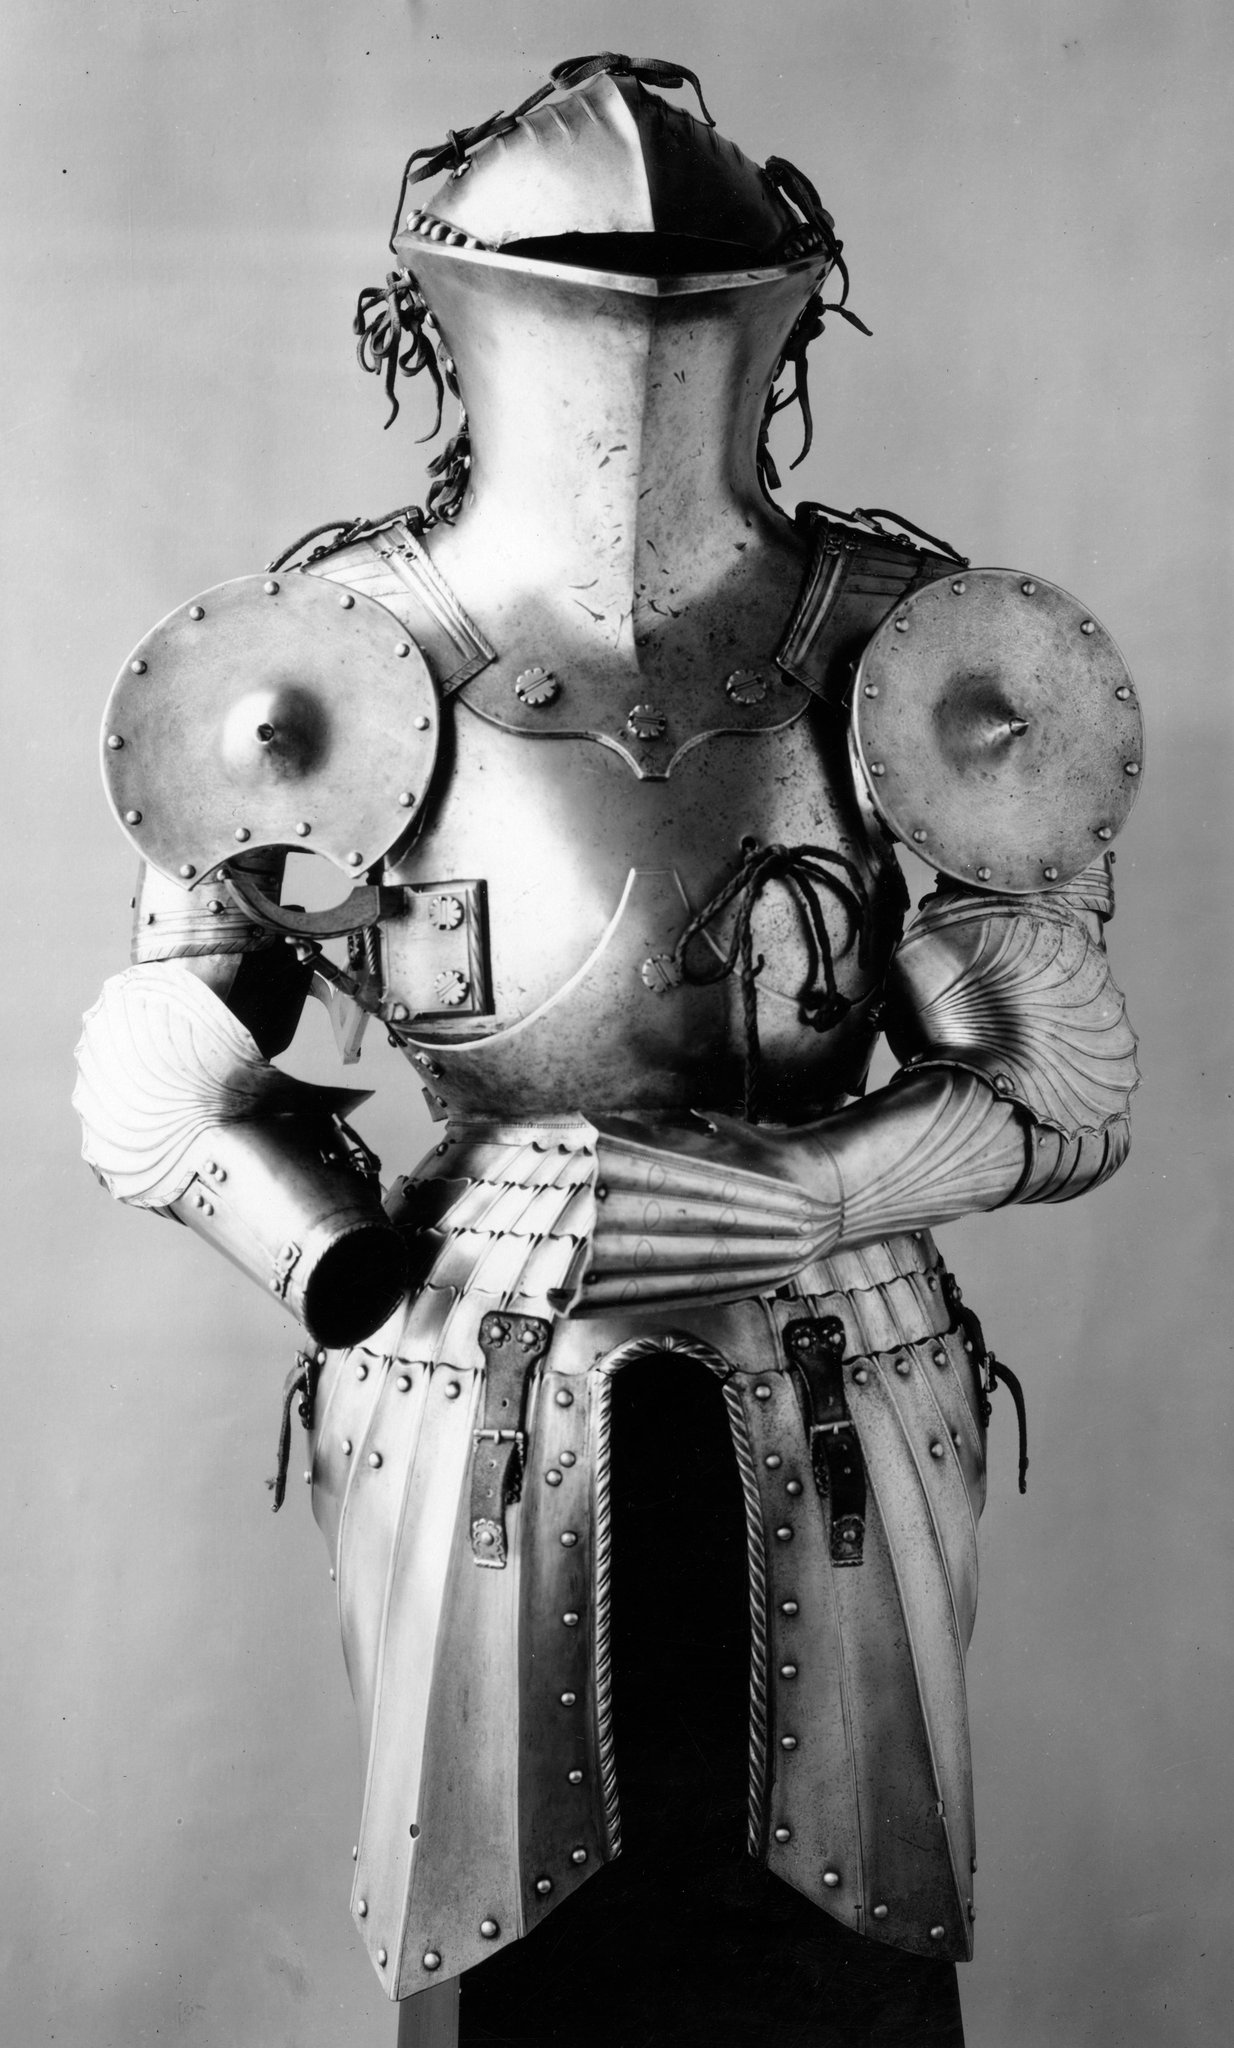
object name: portion of a jousting half armor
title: Portions of a Jousting Half Armor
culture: german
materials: leather, steel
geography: germany